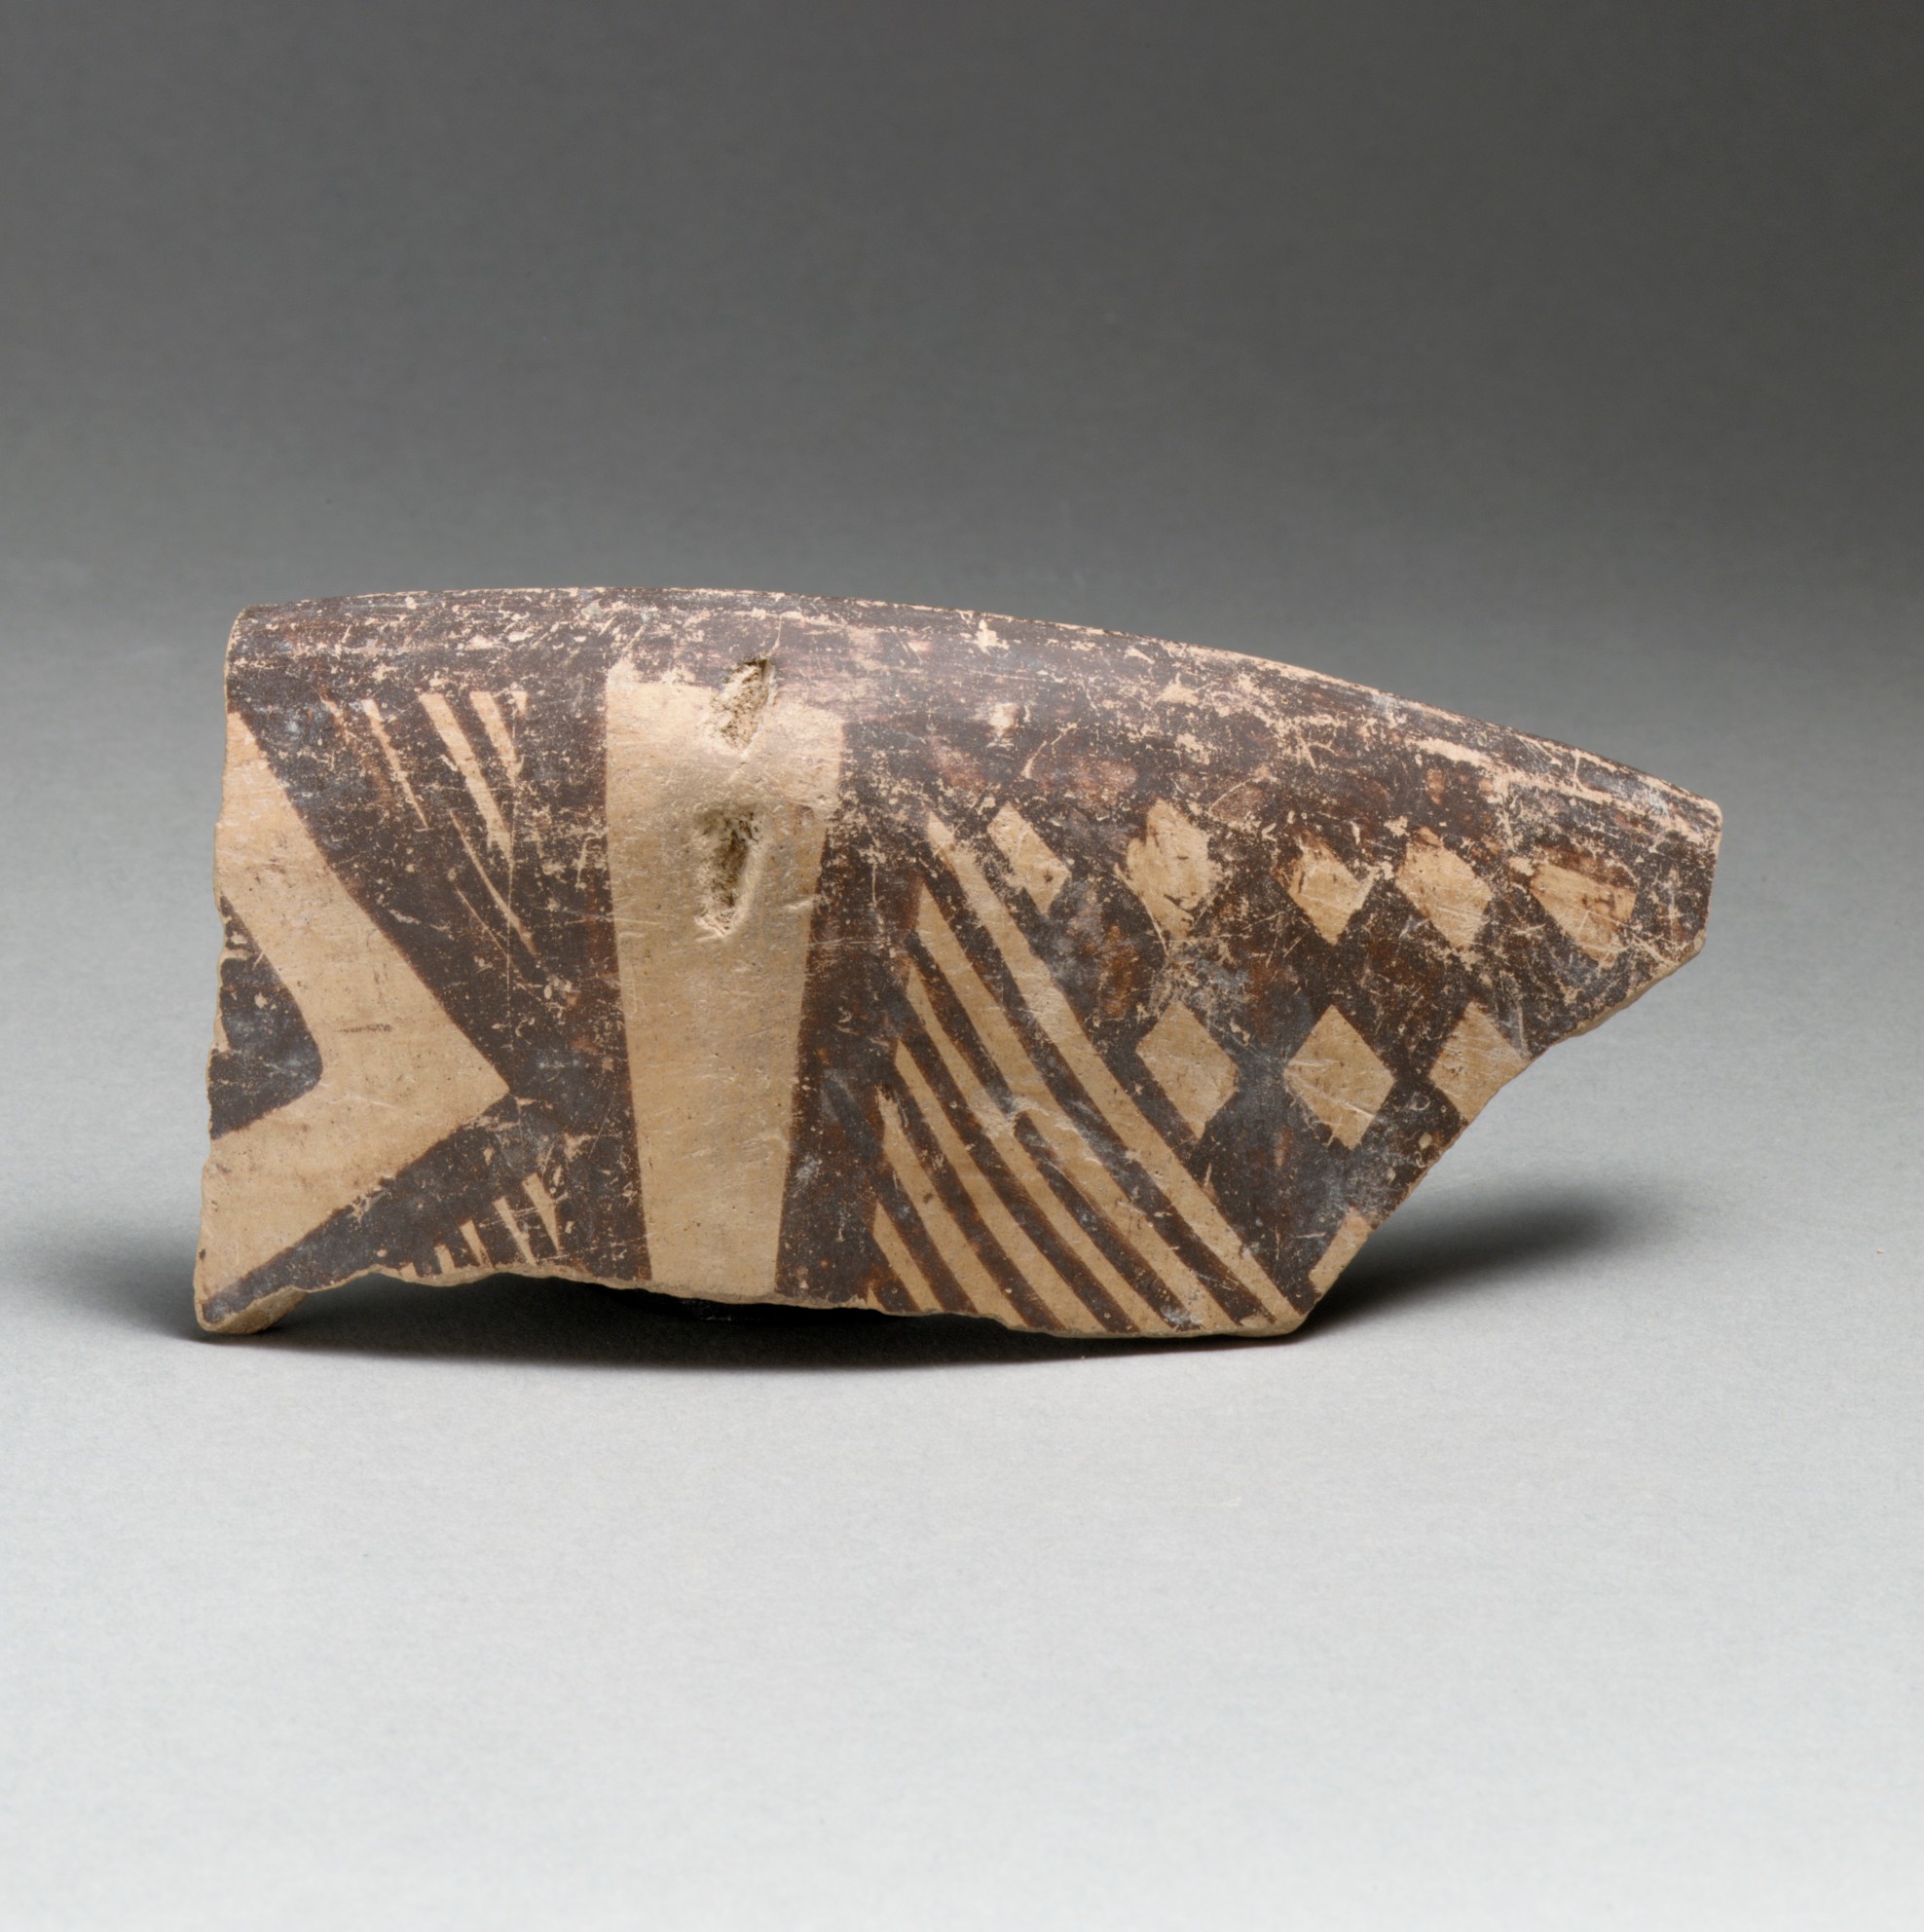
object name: vase fragment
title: Terracotta rim of a bowl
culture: dimini culture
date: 3800-3300 BCE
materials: terracotta